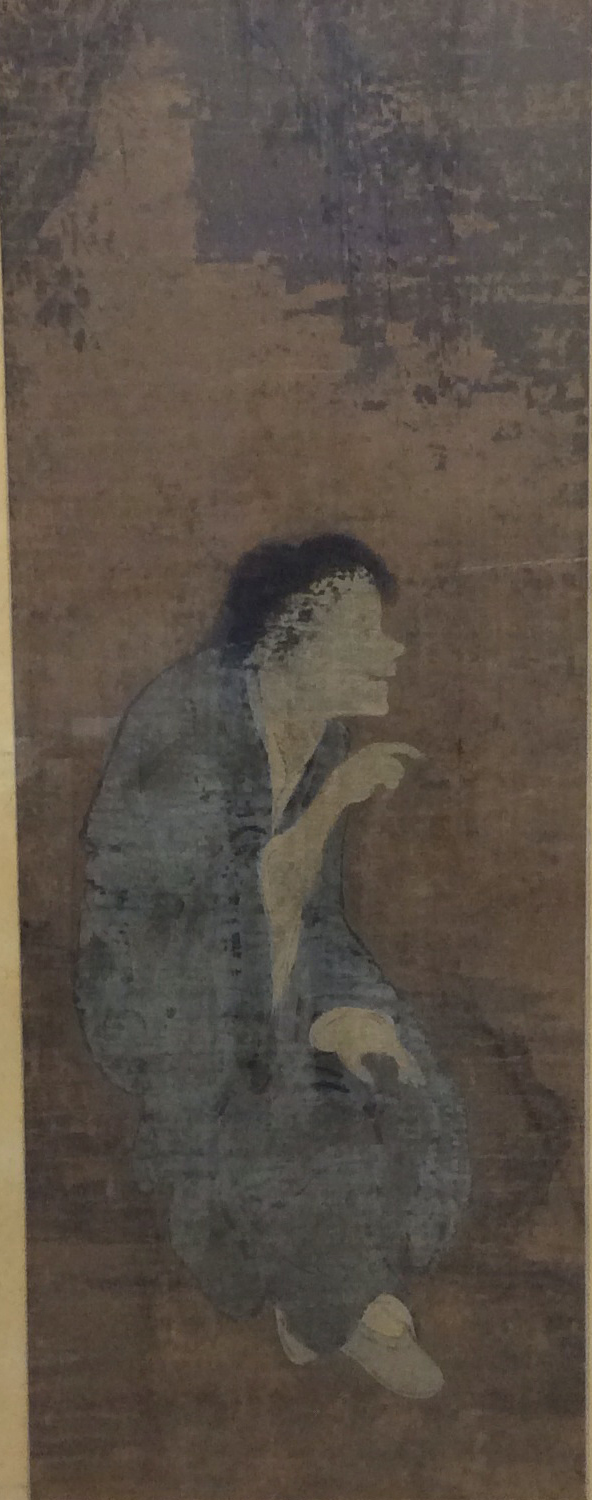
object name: painting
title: Shide, the Buddhist Hermit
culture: chinese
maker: unidentified artist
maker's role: artist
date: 1271-1368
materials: ink, silk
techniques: painting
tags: men